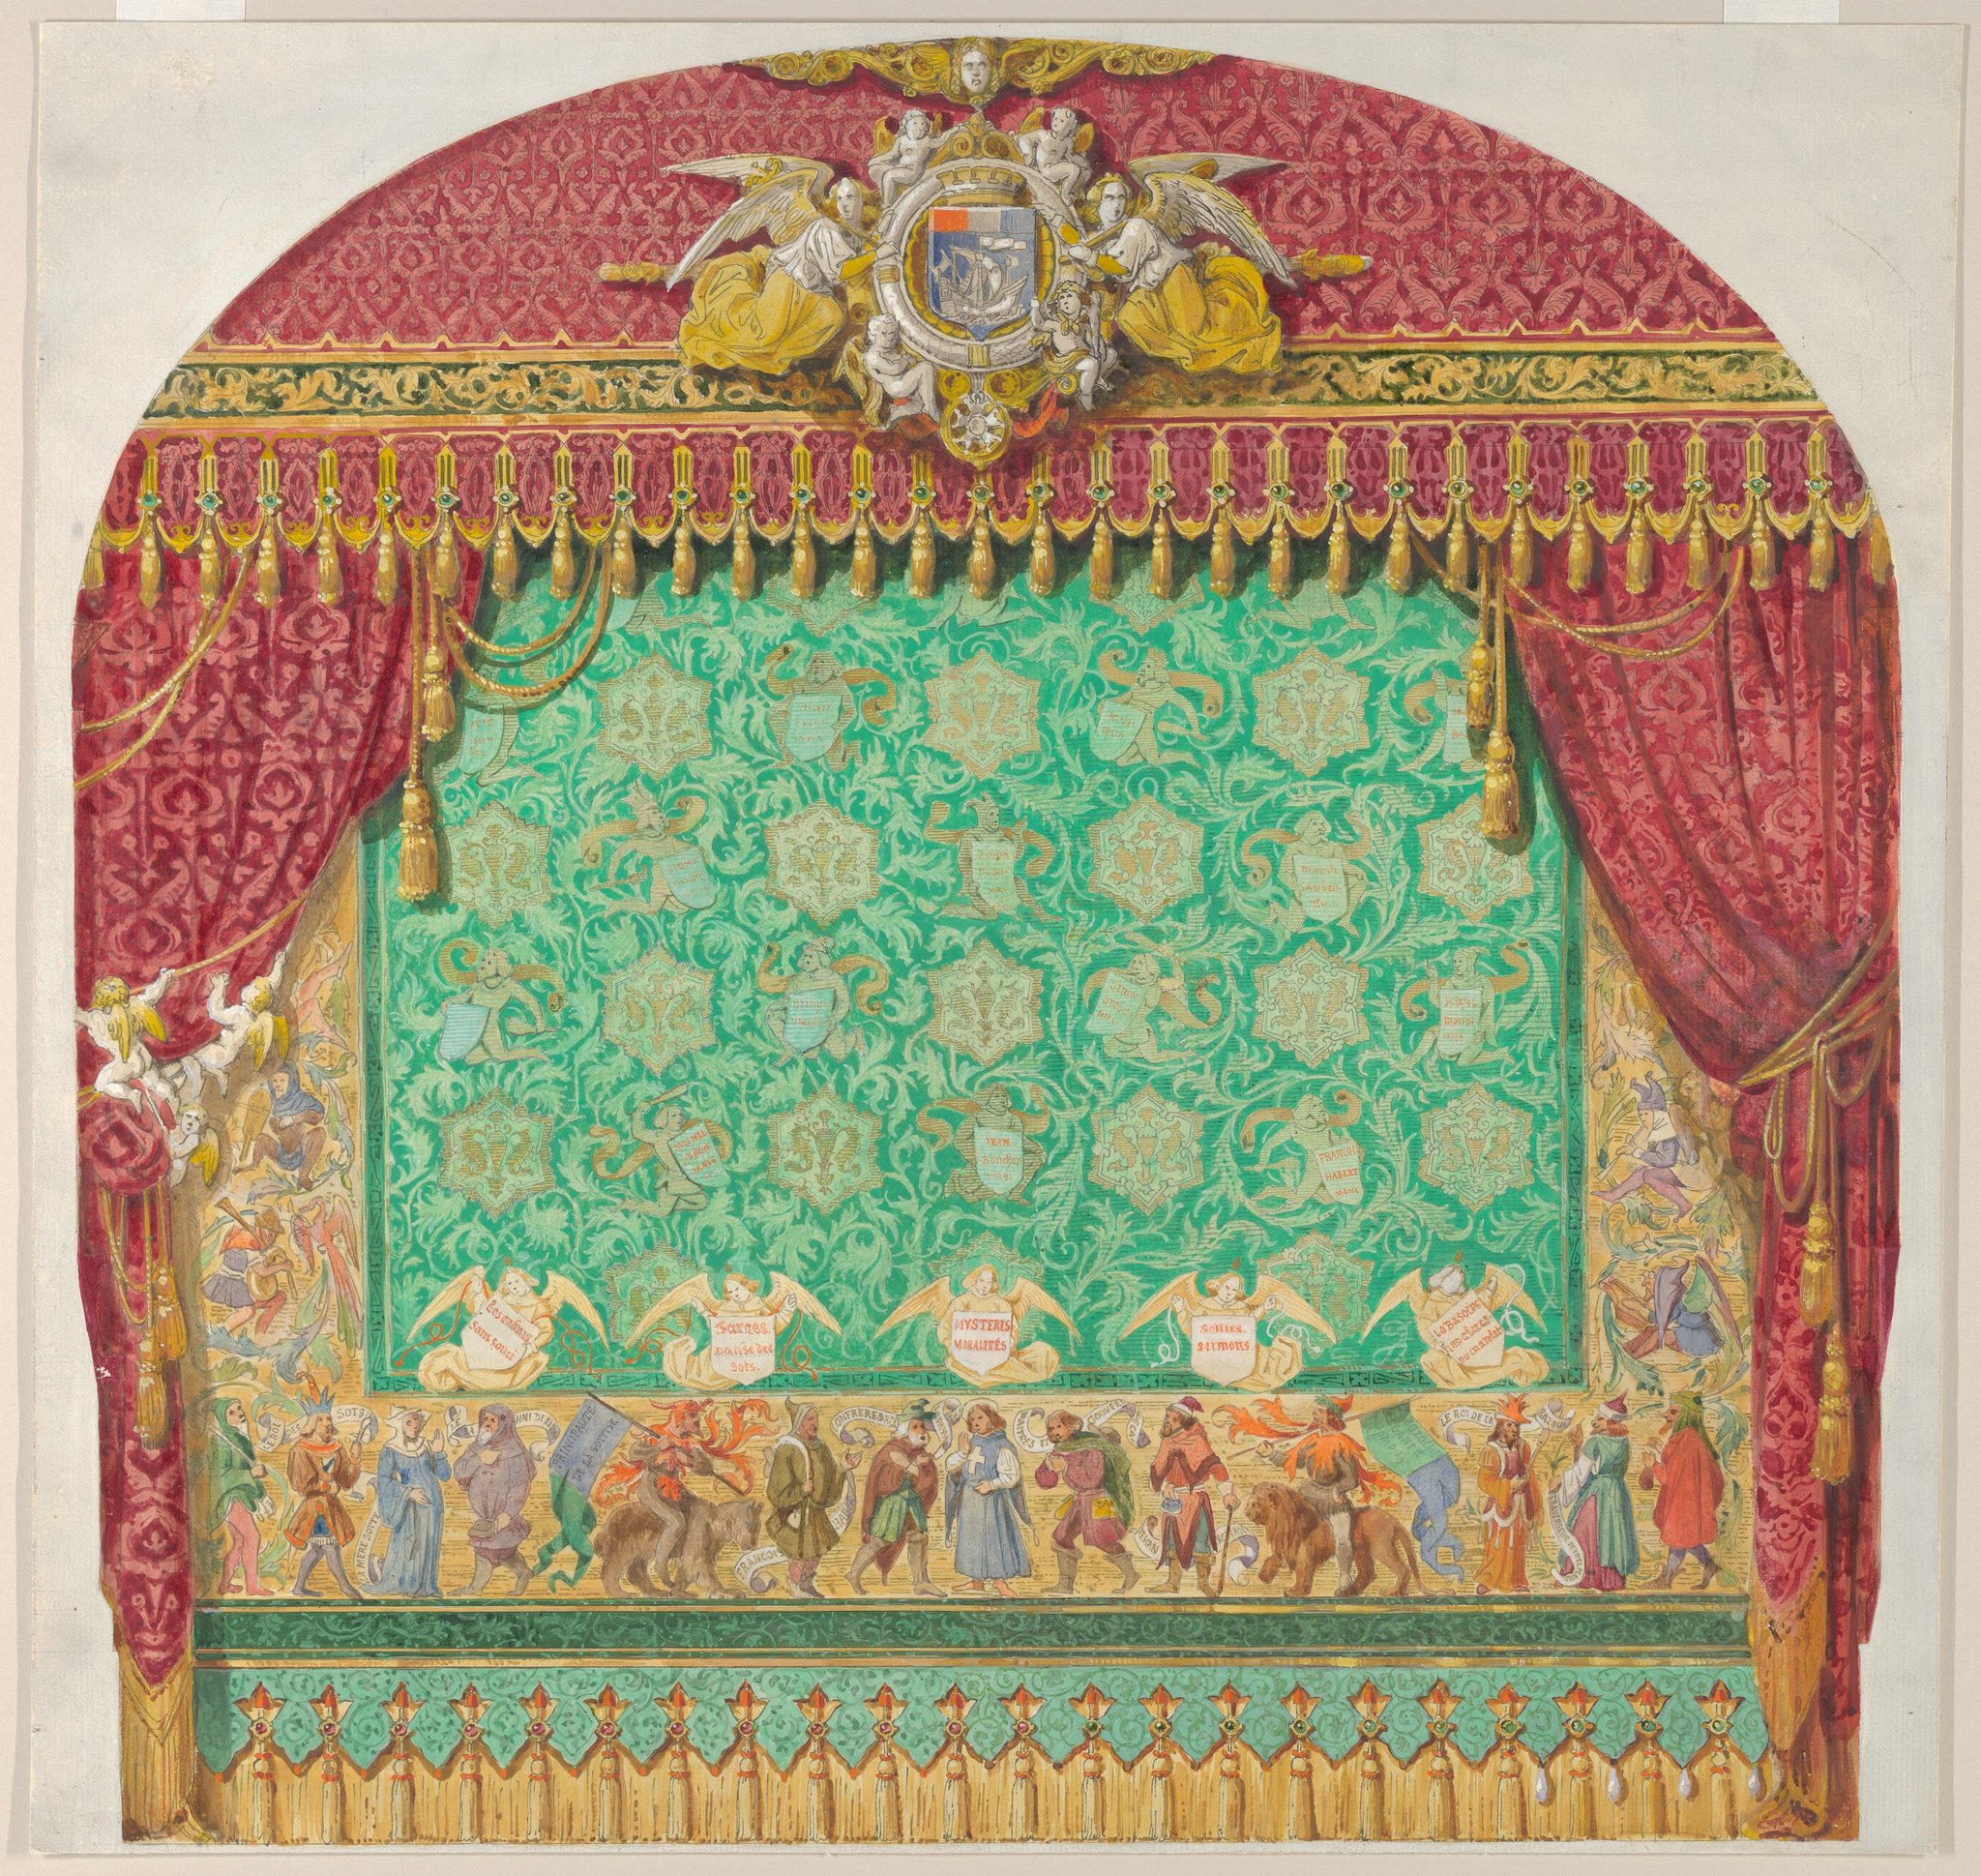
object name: drawing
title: Design for a Theater Curtain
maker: aimé chenavard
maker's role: artist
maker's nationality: french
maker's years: 1798-1838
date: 1818-1838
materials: gilt, gouache, watercolor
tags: theatre,coat of arms,curtains